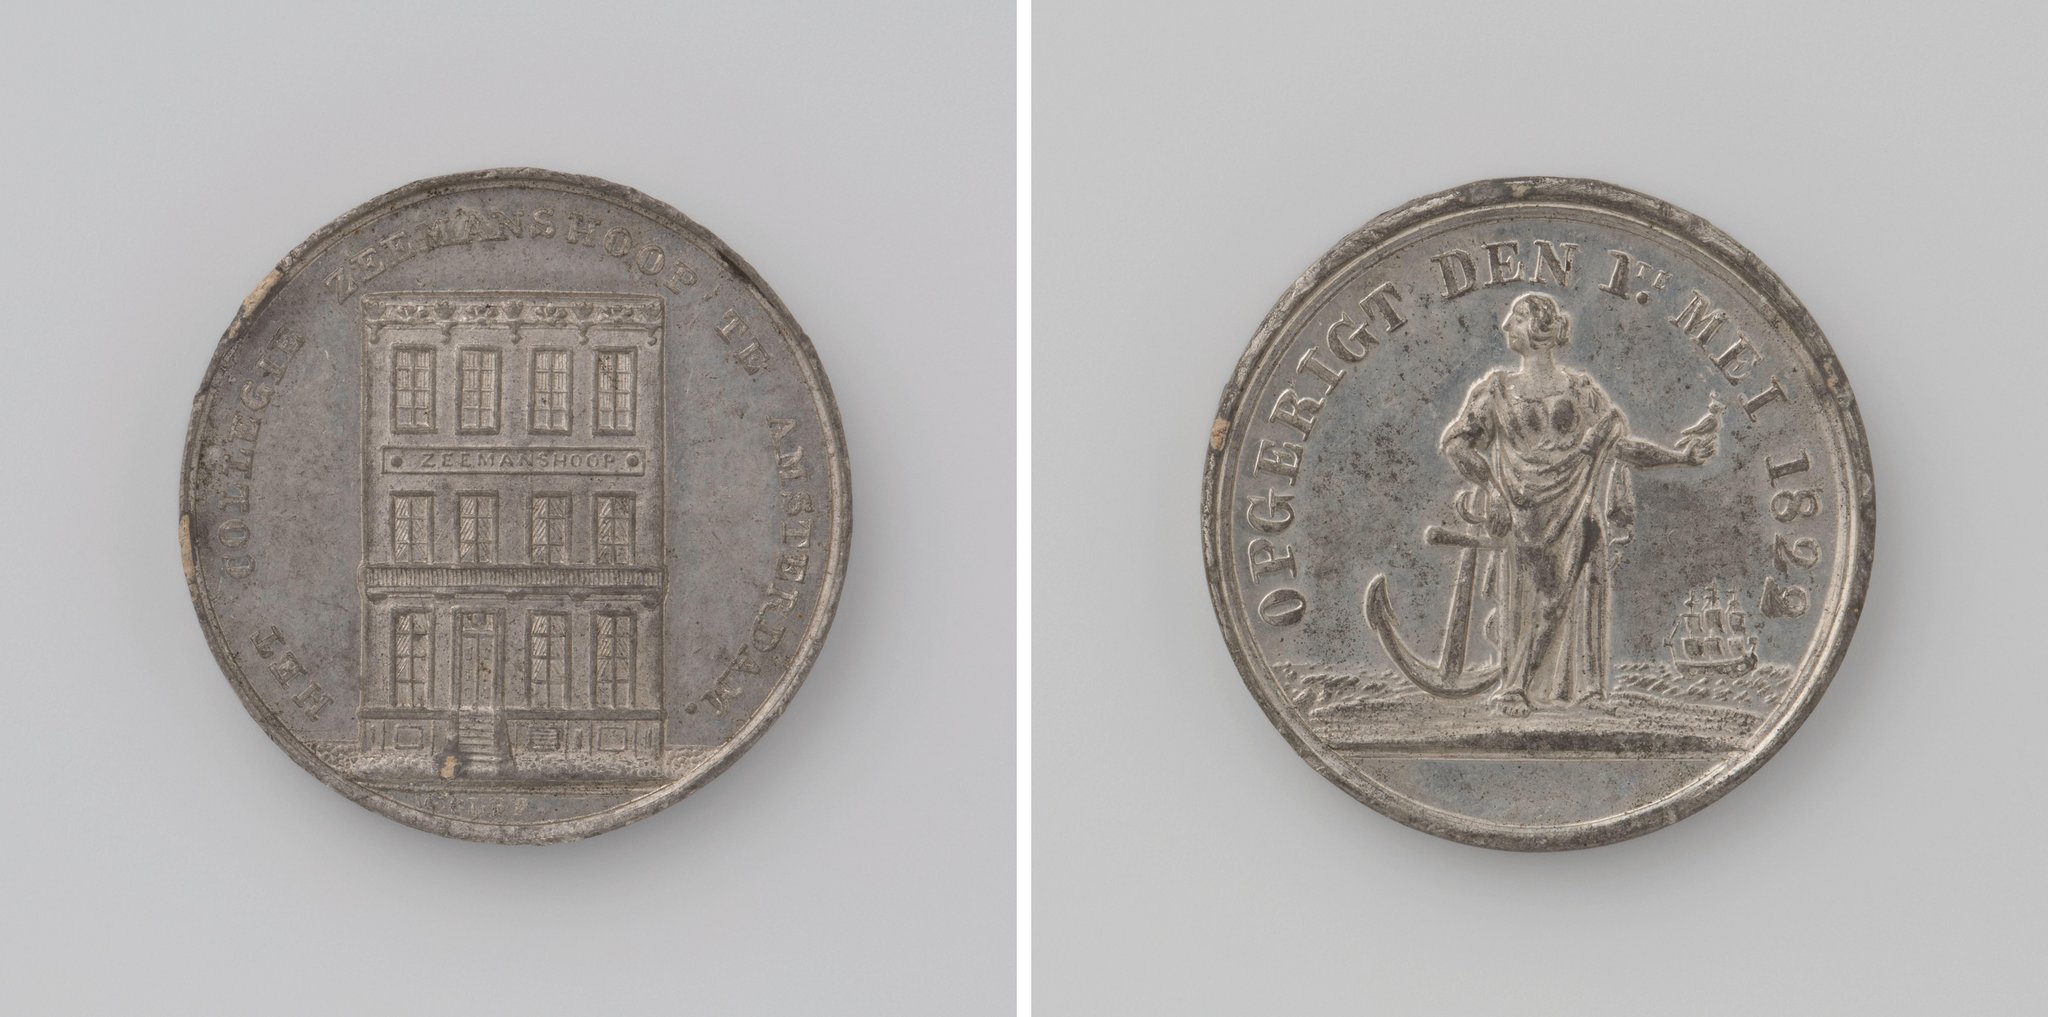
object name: history medal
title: Oprichting van het Collegie Zeemanshoop te Amsterdam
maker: benjamin wolff junior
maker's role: designer, die cutter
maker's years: 1803-1865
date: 1822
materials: tin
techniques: striking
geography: netherlands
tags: amsterdam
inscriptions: signature: ‘WOLFF .’